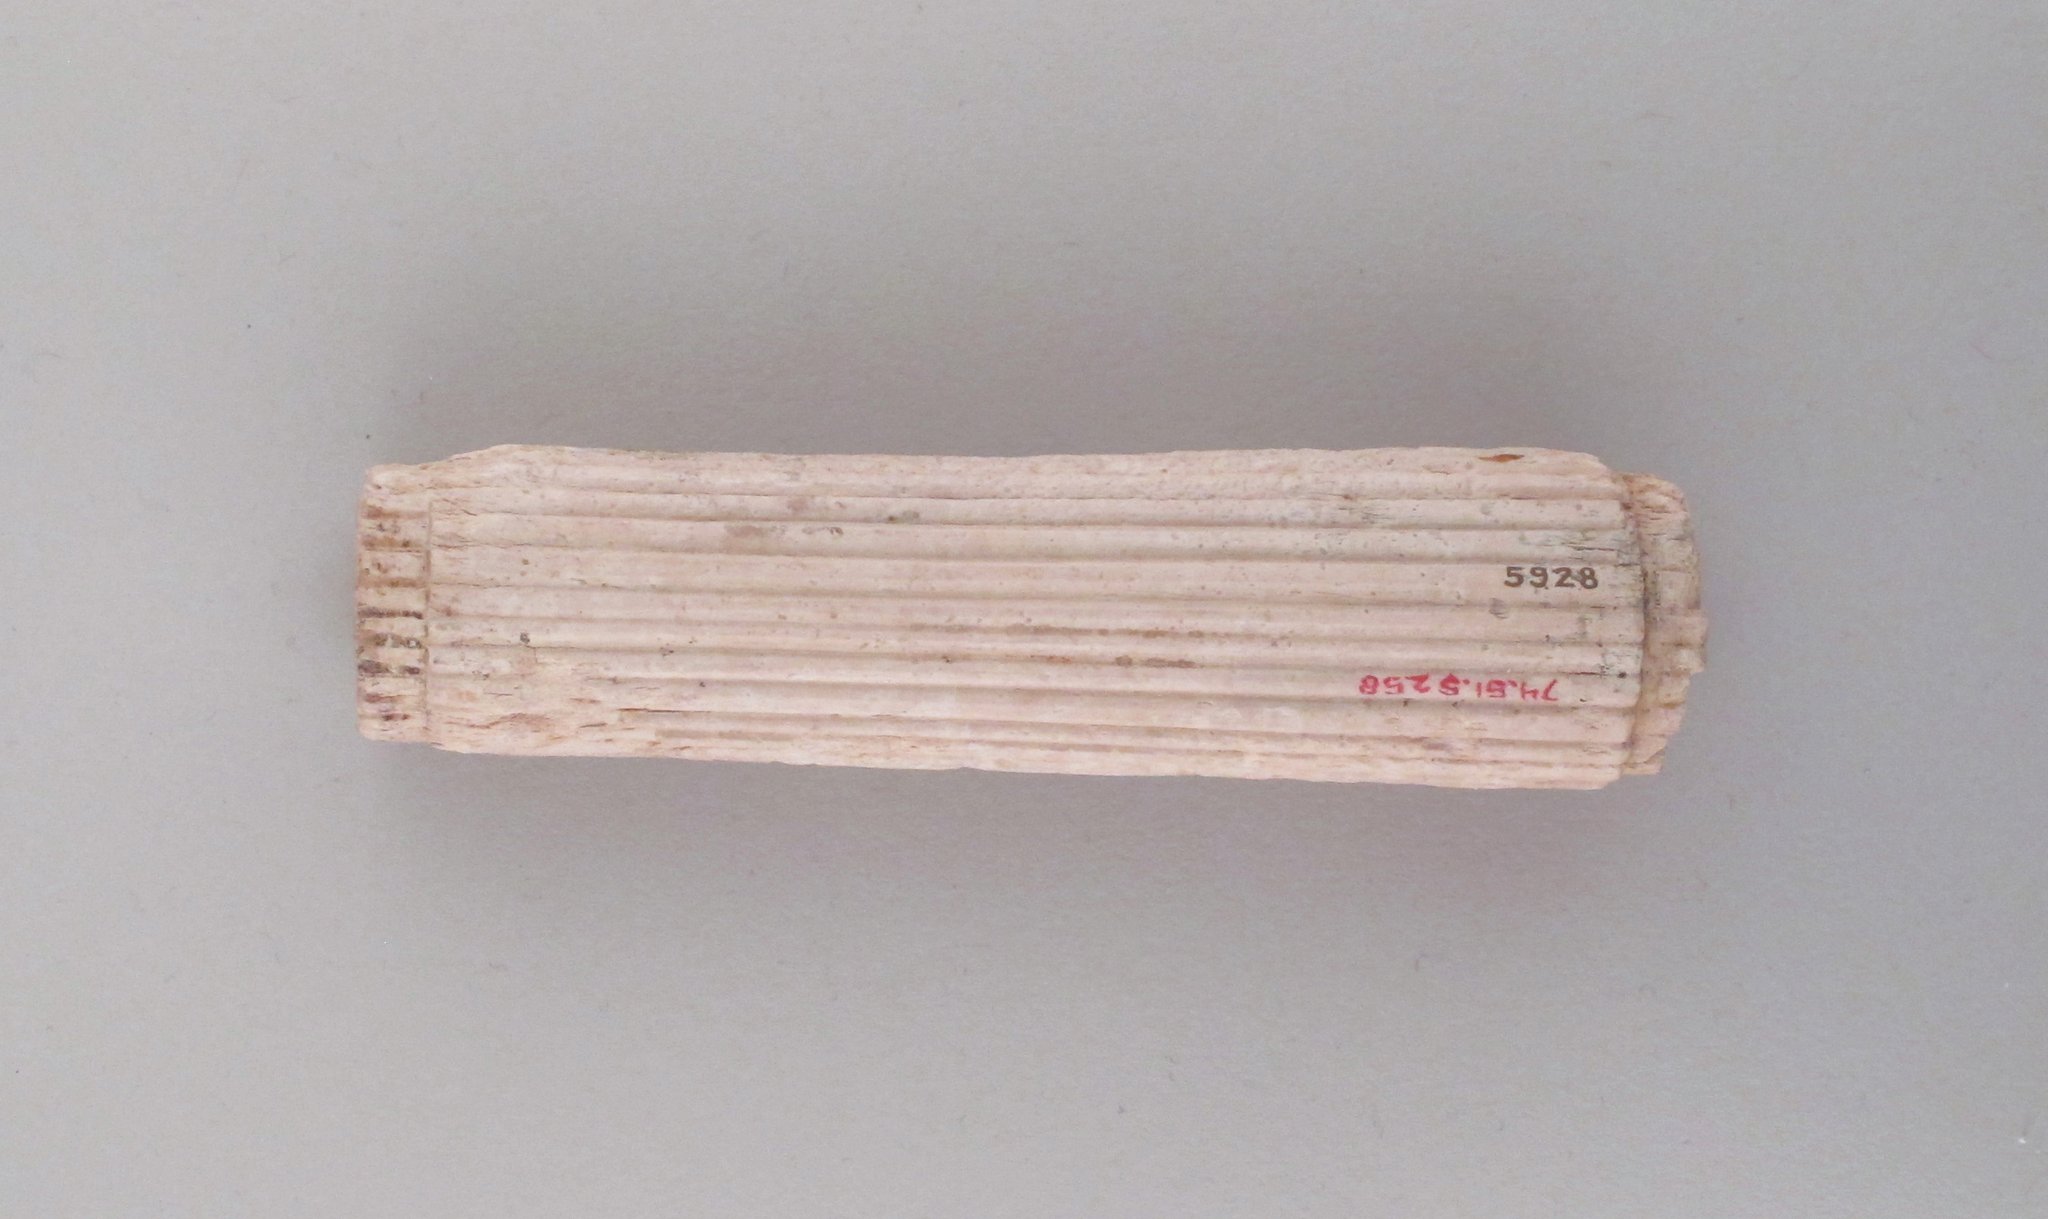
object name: toilet box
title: Toilet box or handle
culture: cypriot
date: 3900 BCE-100 CE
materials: bone